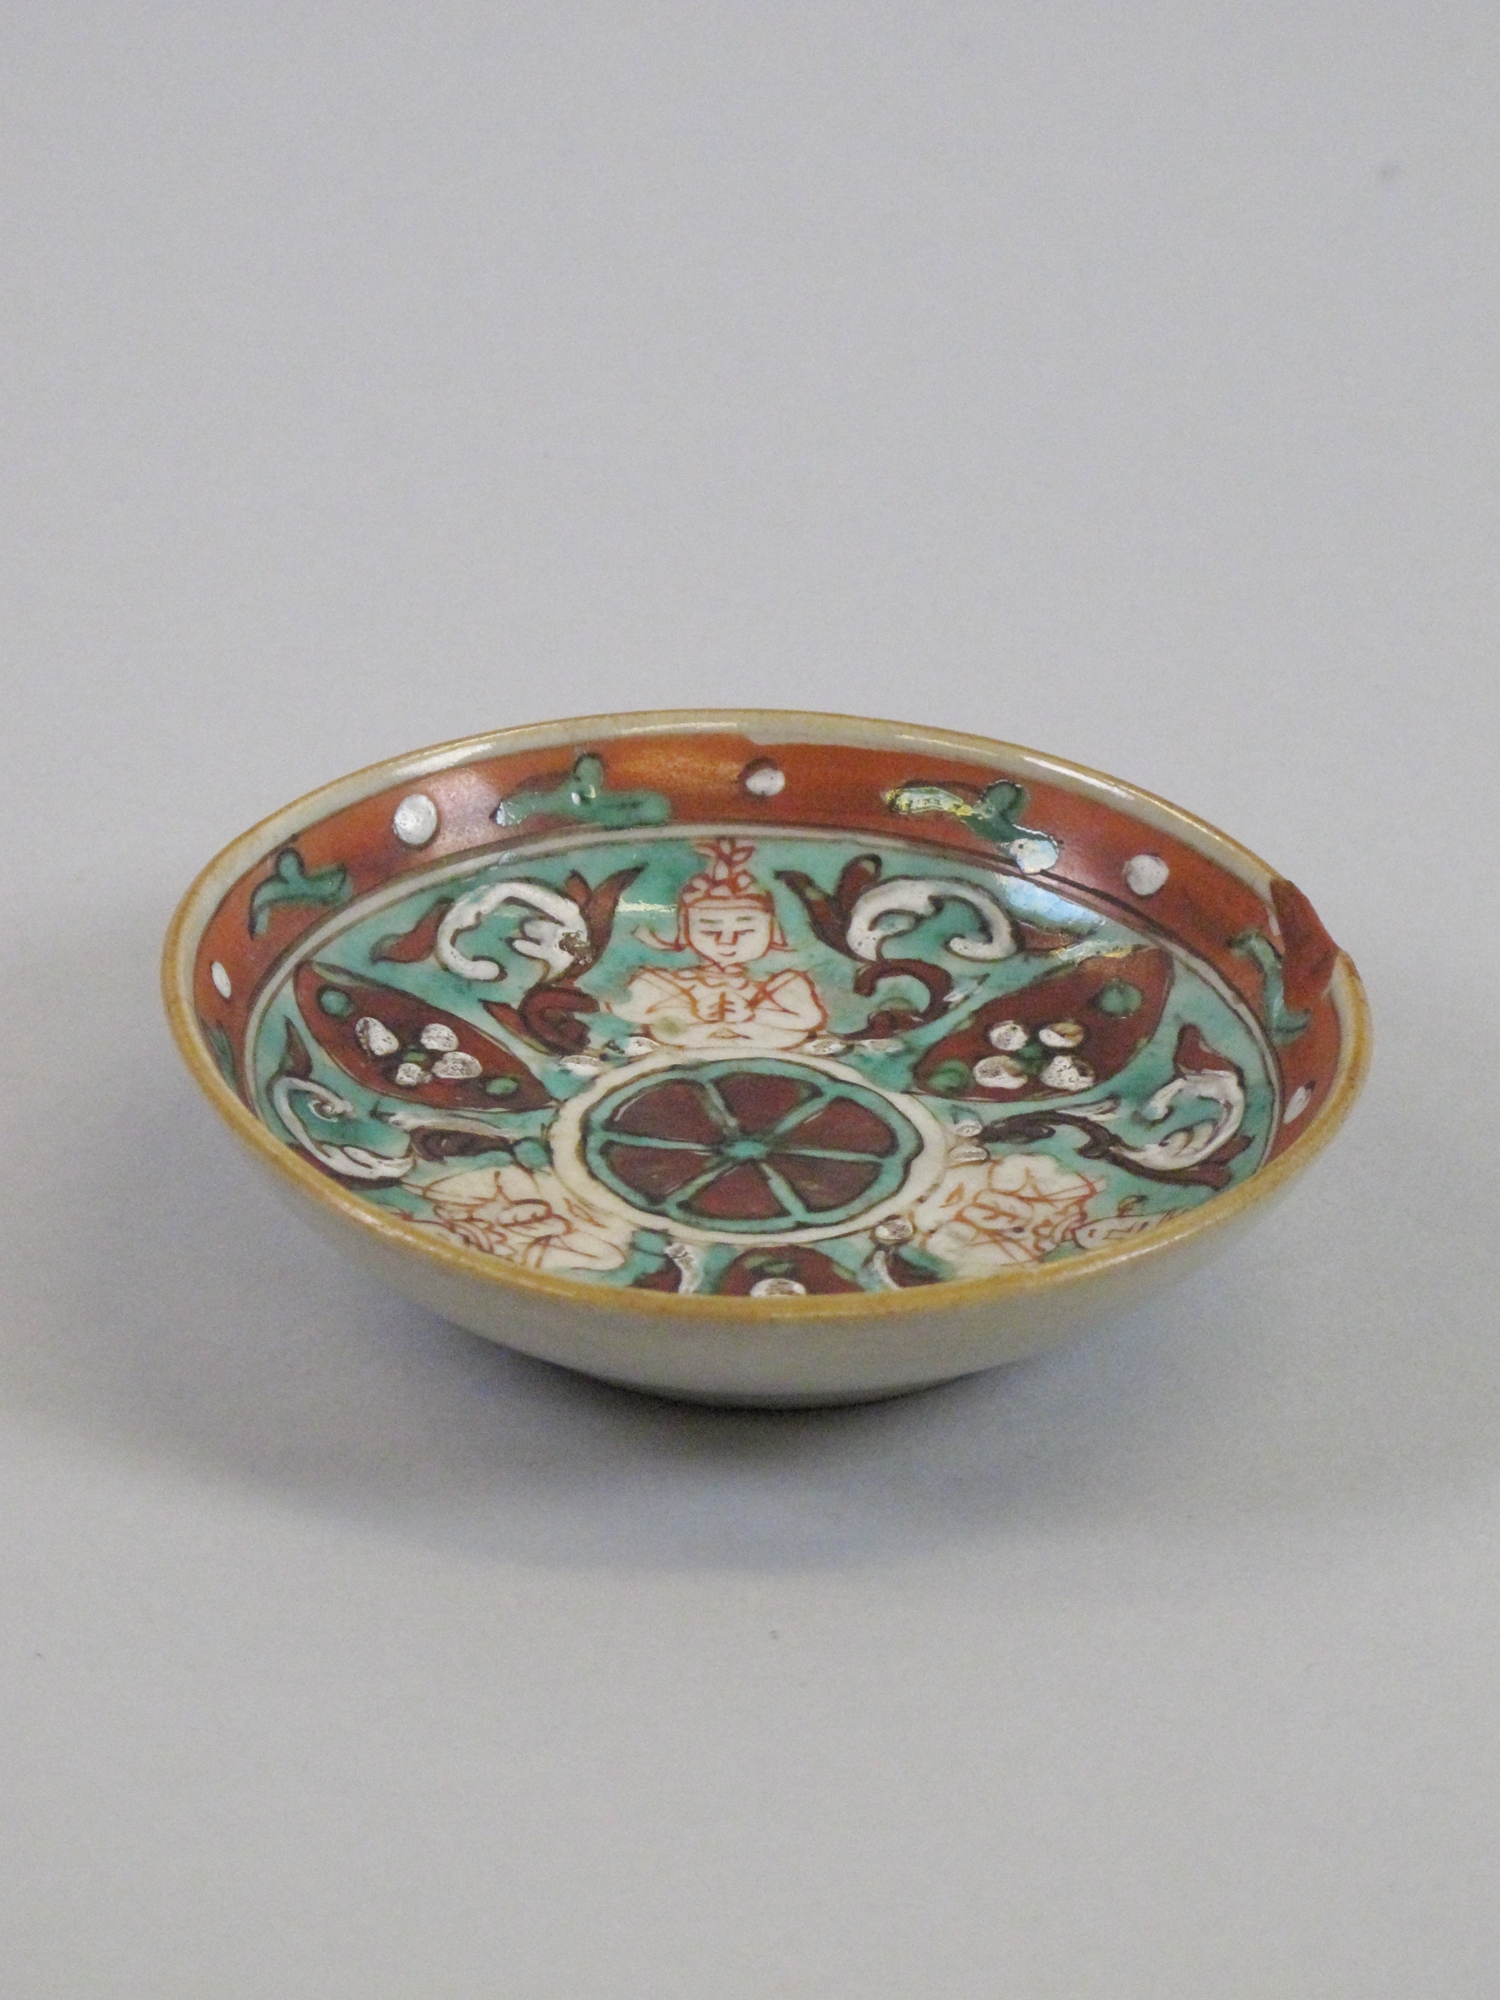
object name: saucer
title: Saucer with Thai mythical figures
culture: chinese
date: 1801-1900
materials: enamel, porcelain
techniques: overglaze, painting, polychrome